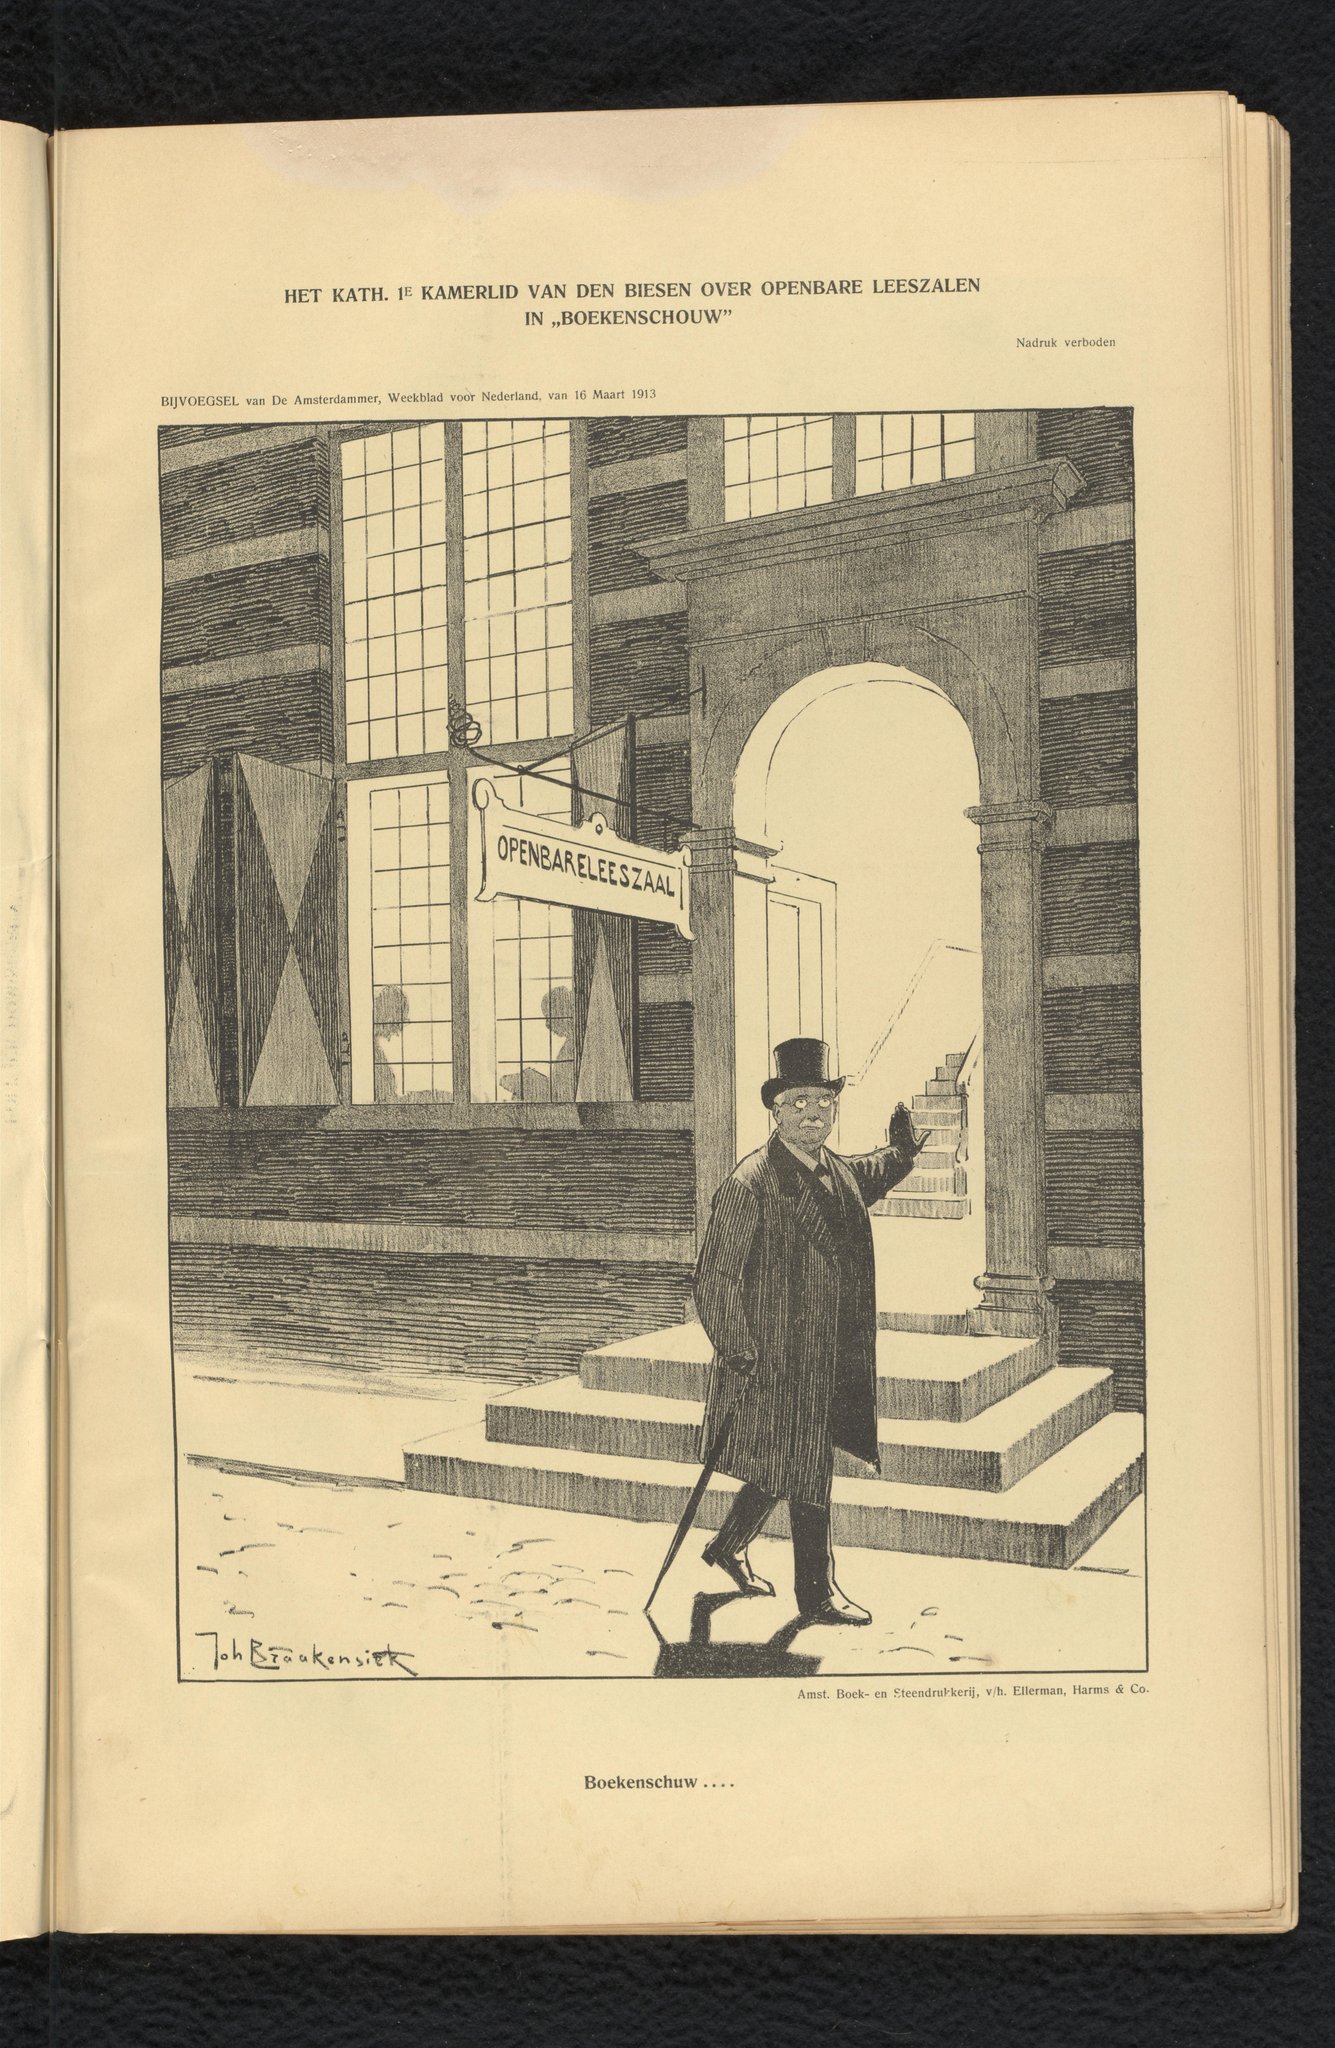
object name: cartoon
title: Het Kath. 1e Kamerlid Van den Biesen over Openbare Leeszalen in "Boekenschouw"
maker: johan braakensiek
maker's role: draughtsman, print maker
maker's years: 1858-1940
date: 1913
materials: paper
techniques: lithograph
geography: amsterdam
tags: censorship, public library, political caricatures and satires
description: Eerste Kamerlid Jacob van den Biesen maakt in het voorbijgaan een afwerend gebaar in de richting van een Openbare Leeszaal. Naar aanleiding van zijn ideeën over de ethische en morele waarde van sommige boeken in het blad Boekenschouw.